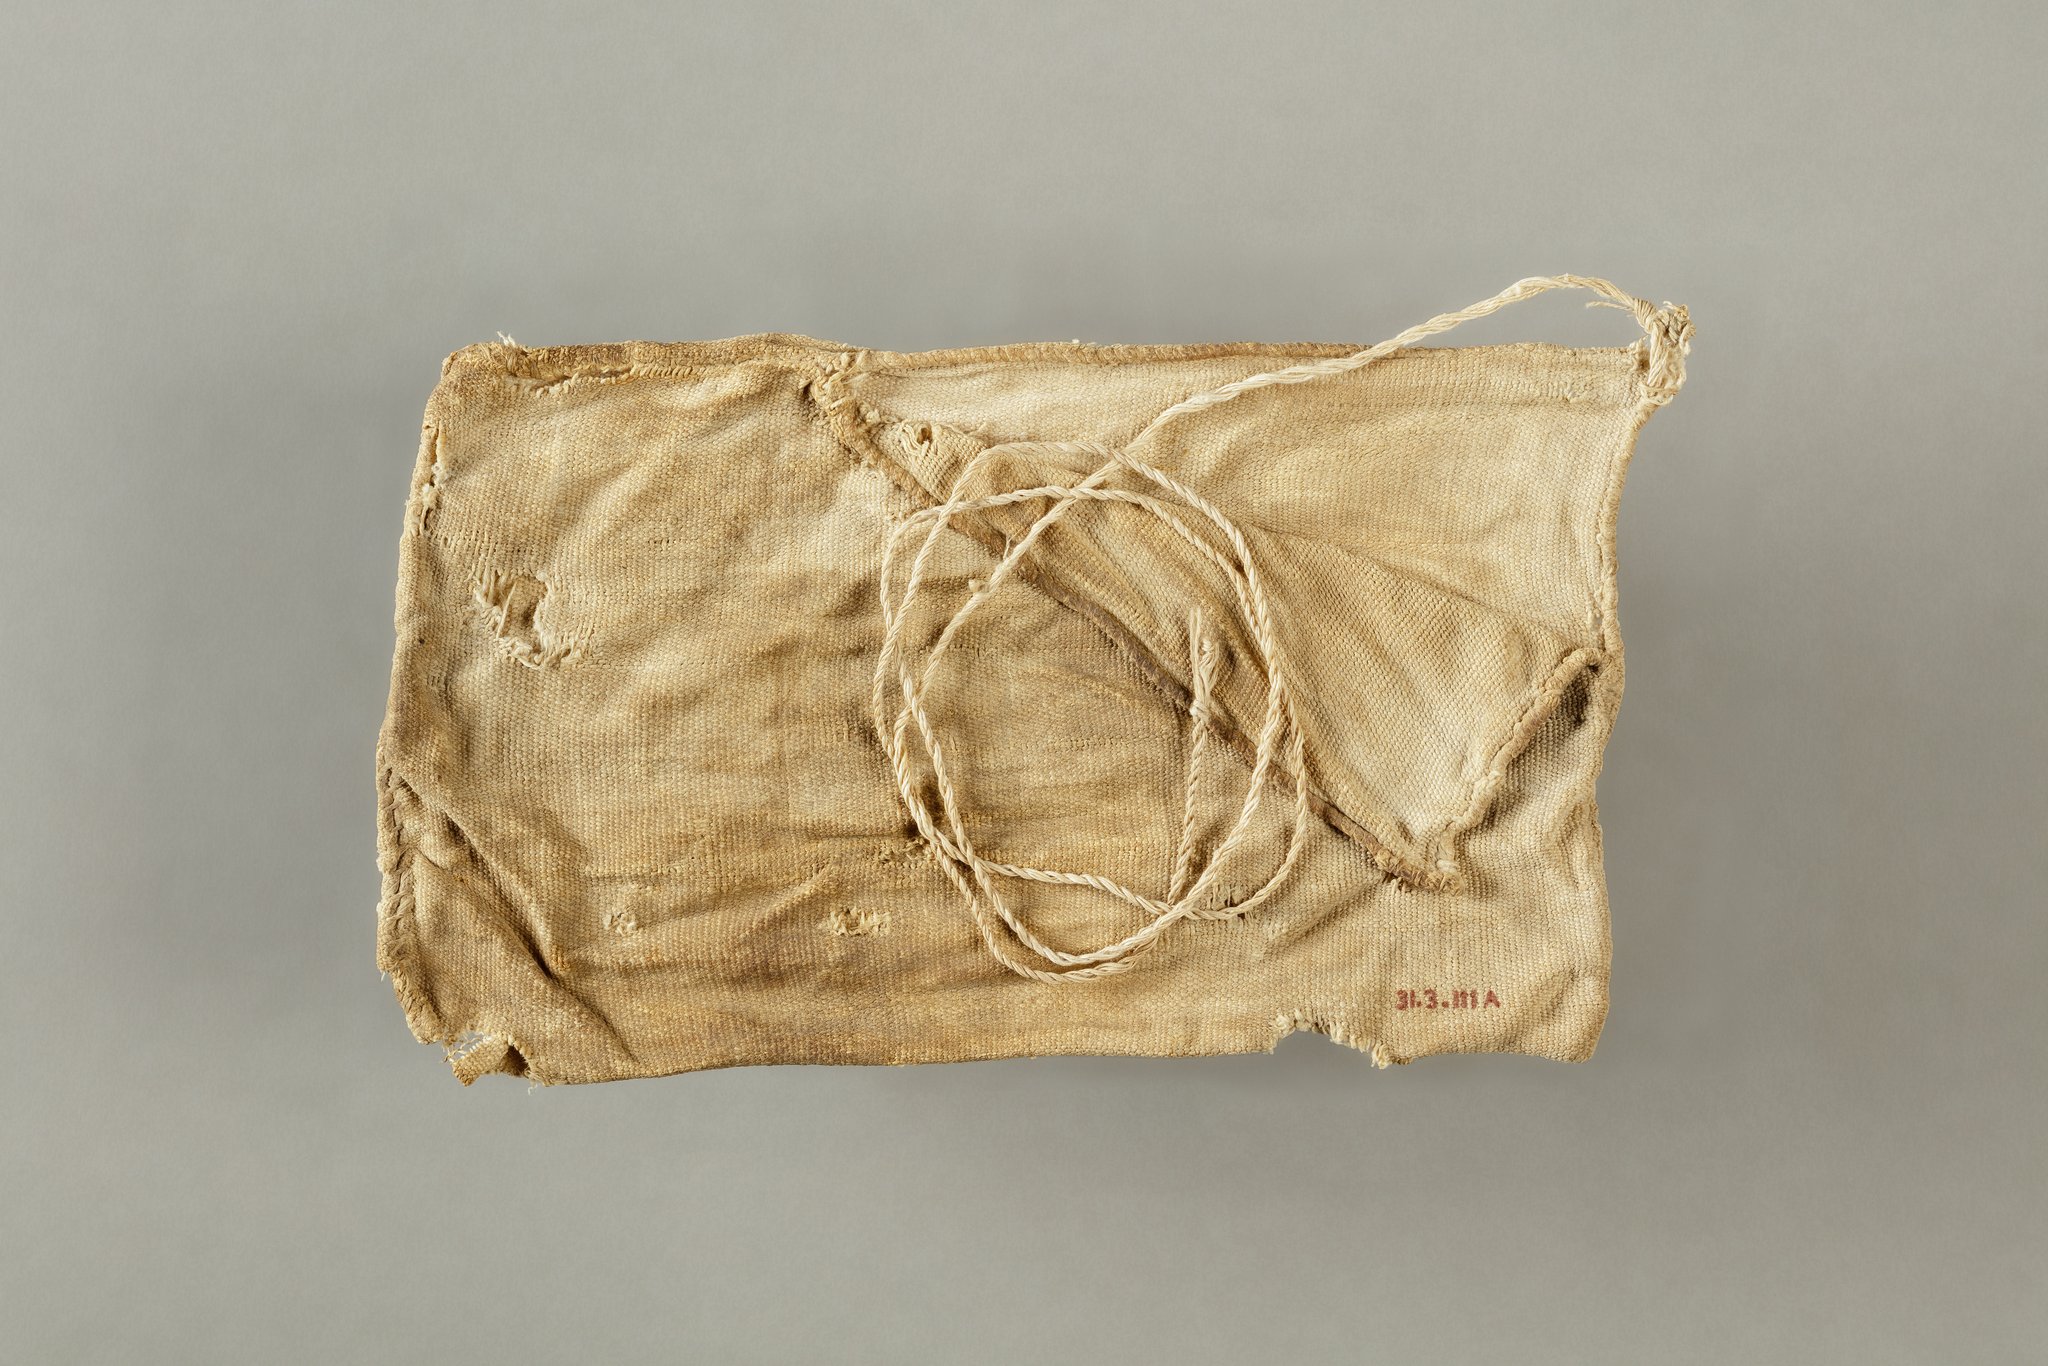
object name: linen bag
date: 664-332 BCE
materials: cord, linen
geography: egypt